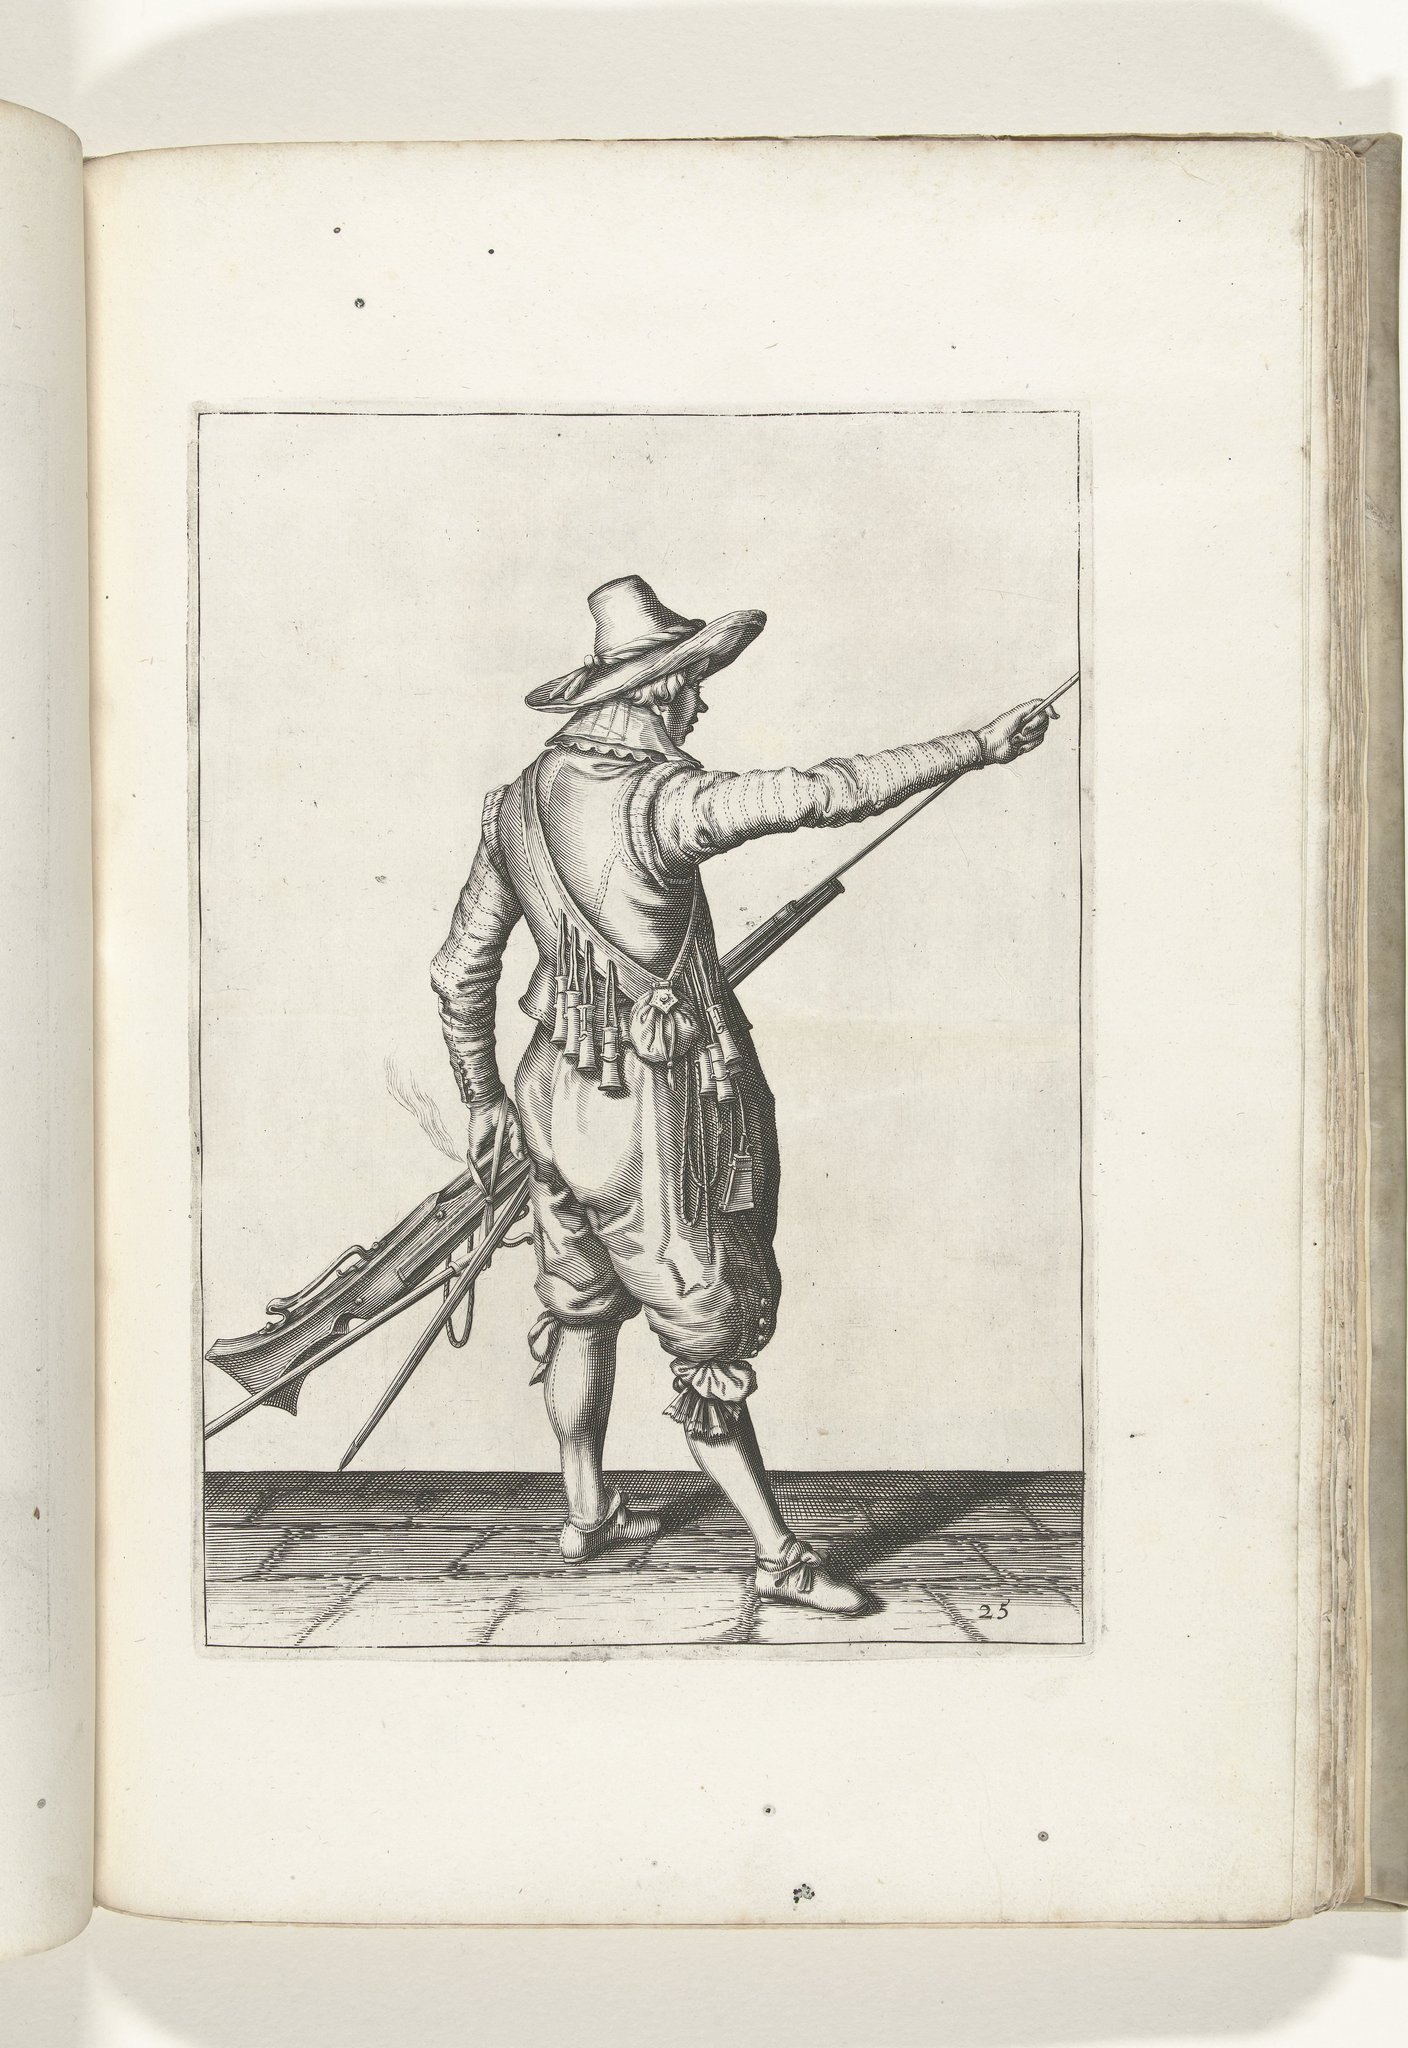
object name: print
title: Soldaat die zijn laadstok uit de houder onder de loop van zijn musket haalt (nr. 25), ca. 1600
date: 1597-1607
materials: paper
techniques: engraving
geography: northern netherlands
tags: the hague, maurice (prince of orange), handling of weapons ~ military training, weapons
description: Een soldaat, ten voeten uit, naar rechts, op de rug gezien, die met zijn linkerhand bij zijn linkerdijbeen een musket (een bepaald type vuurwapen) vasthoudt en met zijn rechterhand de laadstok uit de houder onder de loop haalt (nr. 25), ca. 1600. In zijn linkerhand behalve het musket ook een brandende lont; aan zijn linkerpols een furket (musketvork). Plaat 25 in de instructies voor het hanteren van het musket: Corte onderrechtinghe op de figuerliicke afbeeldinghe, soo veel aengaet het recht ghebruyck vant Musquet. Onderdeel van de illustraties in: J. de Gheyn, Wapenhandelinghe van Roers Musquetten ende spiessen, 's-Gravenhage, 1607. Krijgswezen rond 1600.